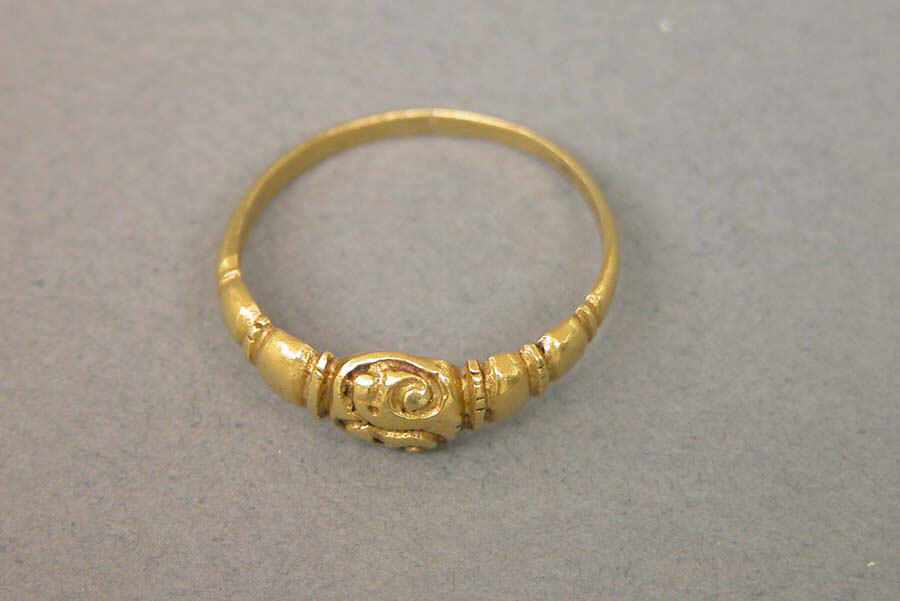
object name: ring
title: Ring with Raised Circular Bezel and Ribbed Hoop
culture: indonesian, javanese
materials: gold